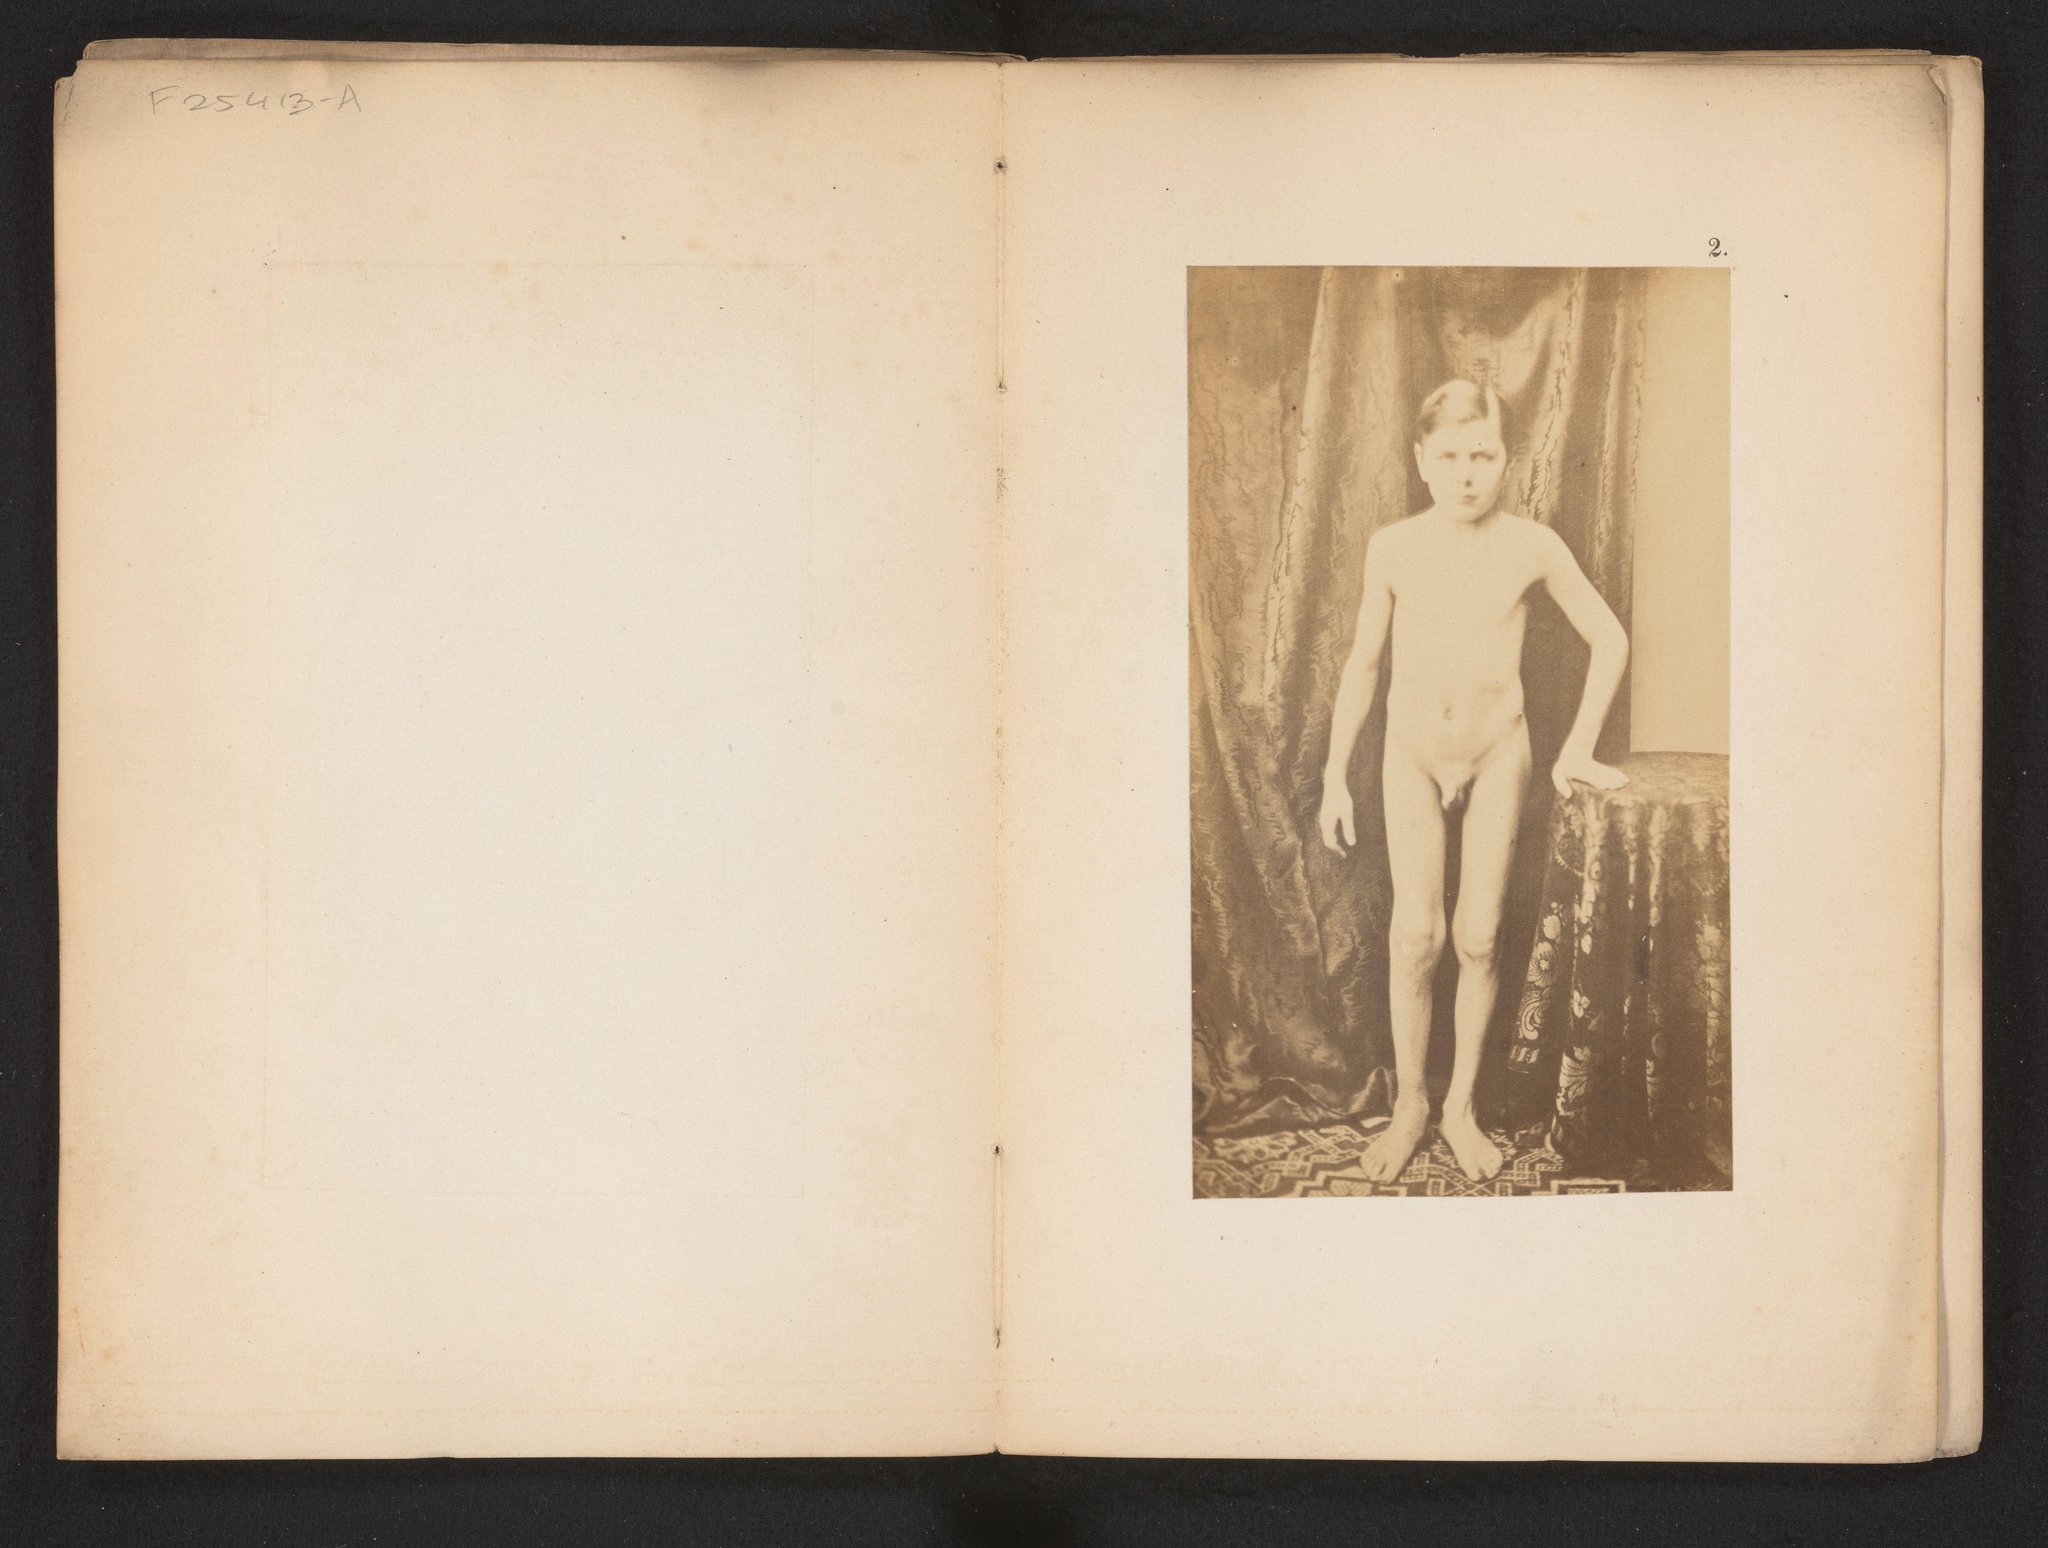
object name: page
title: Portret van een onbekende naakte jongen met heupafwijking, ventraal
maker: Anonymous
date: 1858-1863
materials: paper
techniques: albumen print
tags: boy (child between toddler and youth), medical examination, medical treatment, historical persons not known by name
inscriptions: number: ‘2.’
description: Foto op vijfde ongenummerde pagina na pagina 38.